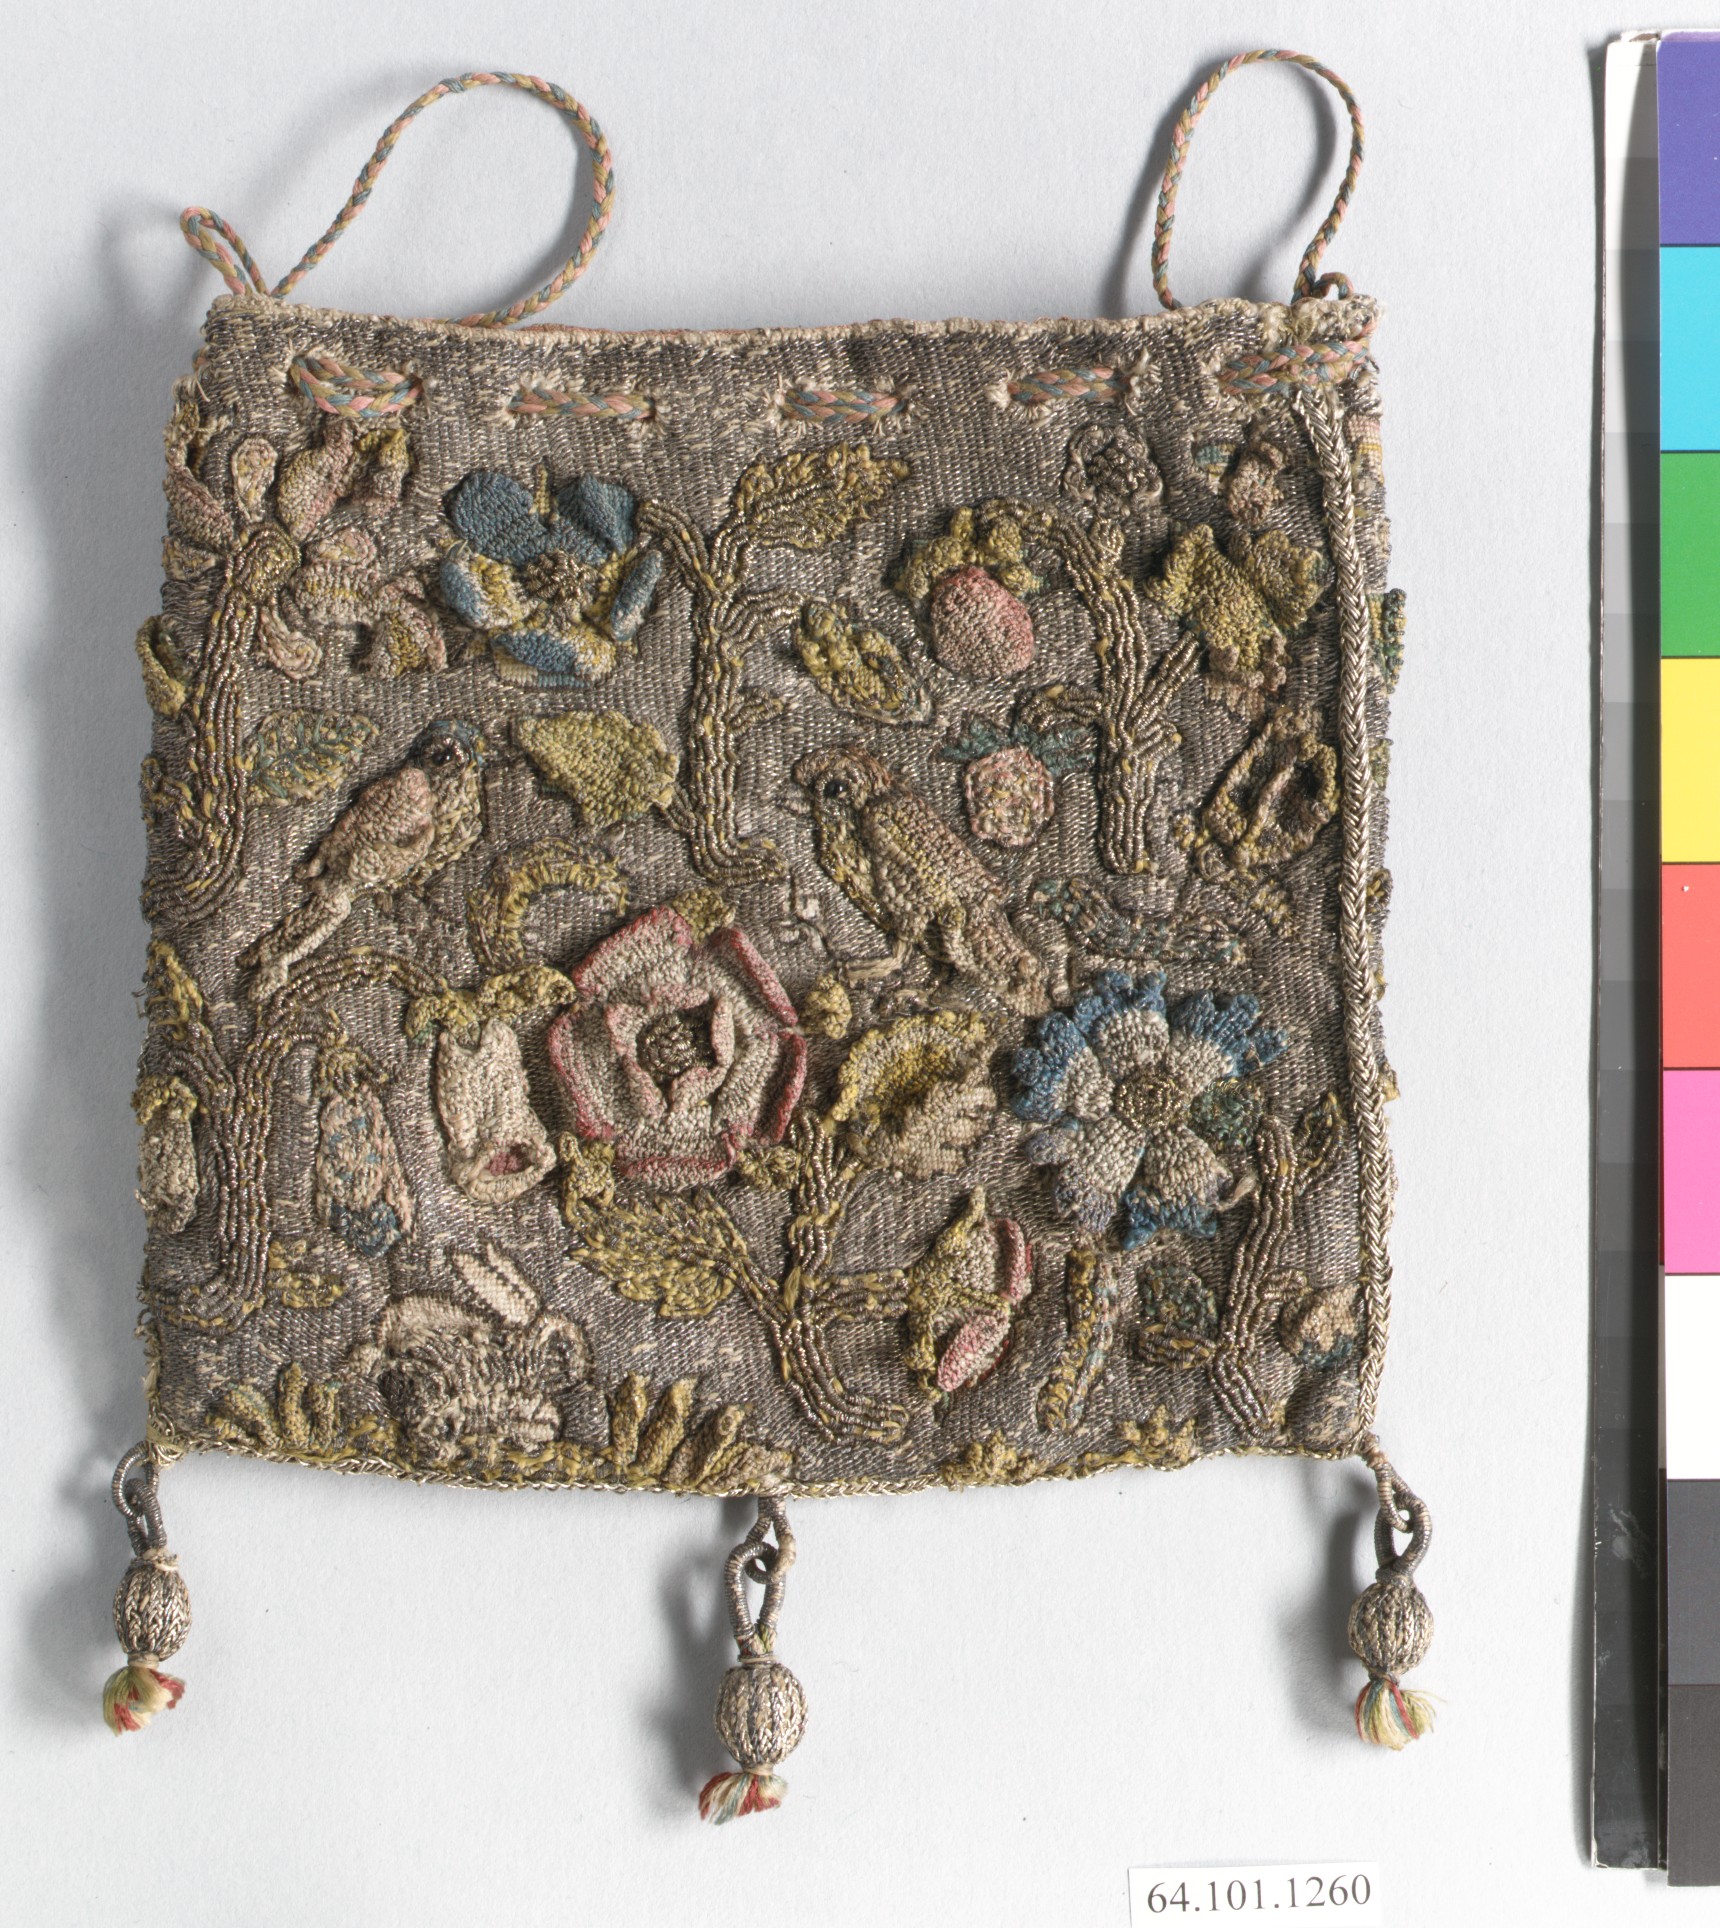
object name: purse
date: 1601-1625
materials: canvas, metal thread, silk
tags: birds,flowers